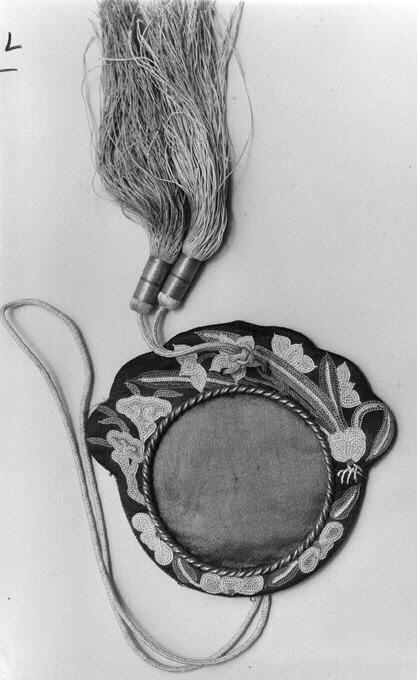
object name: mirror case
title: Watch Case with Floral Decoration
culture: chinese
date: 1801-1900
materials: textile, silk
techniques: embroidery